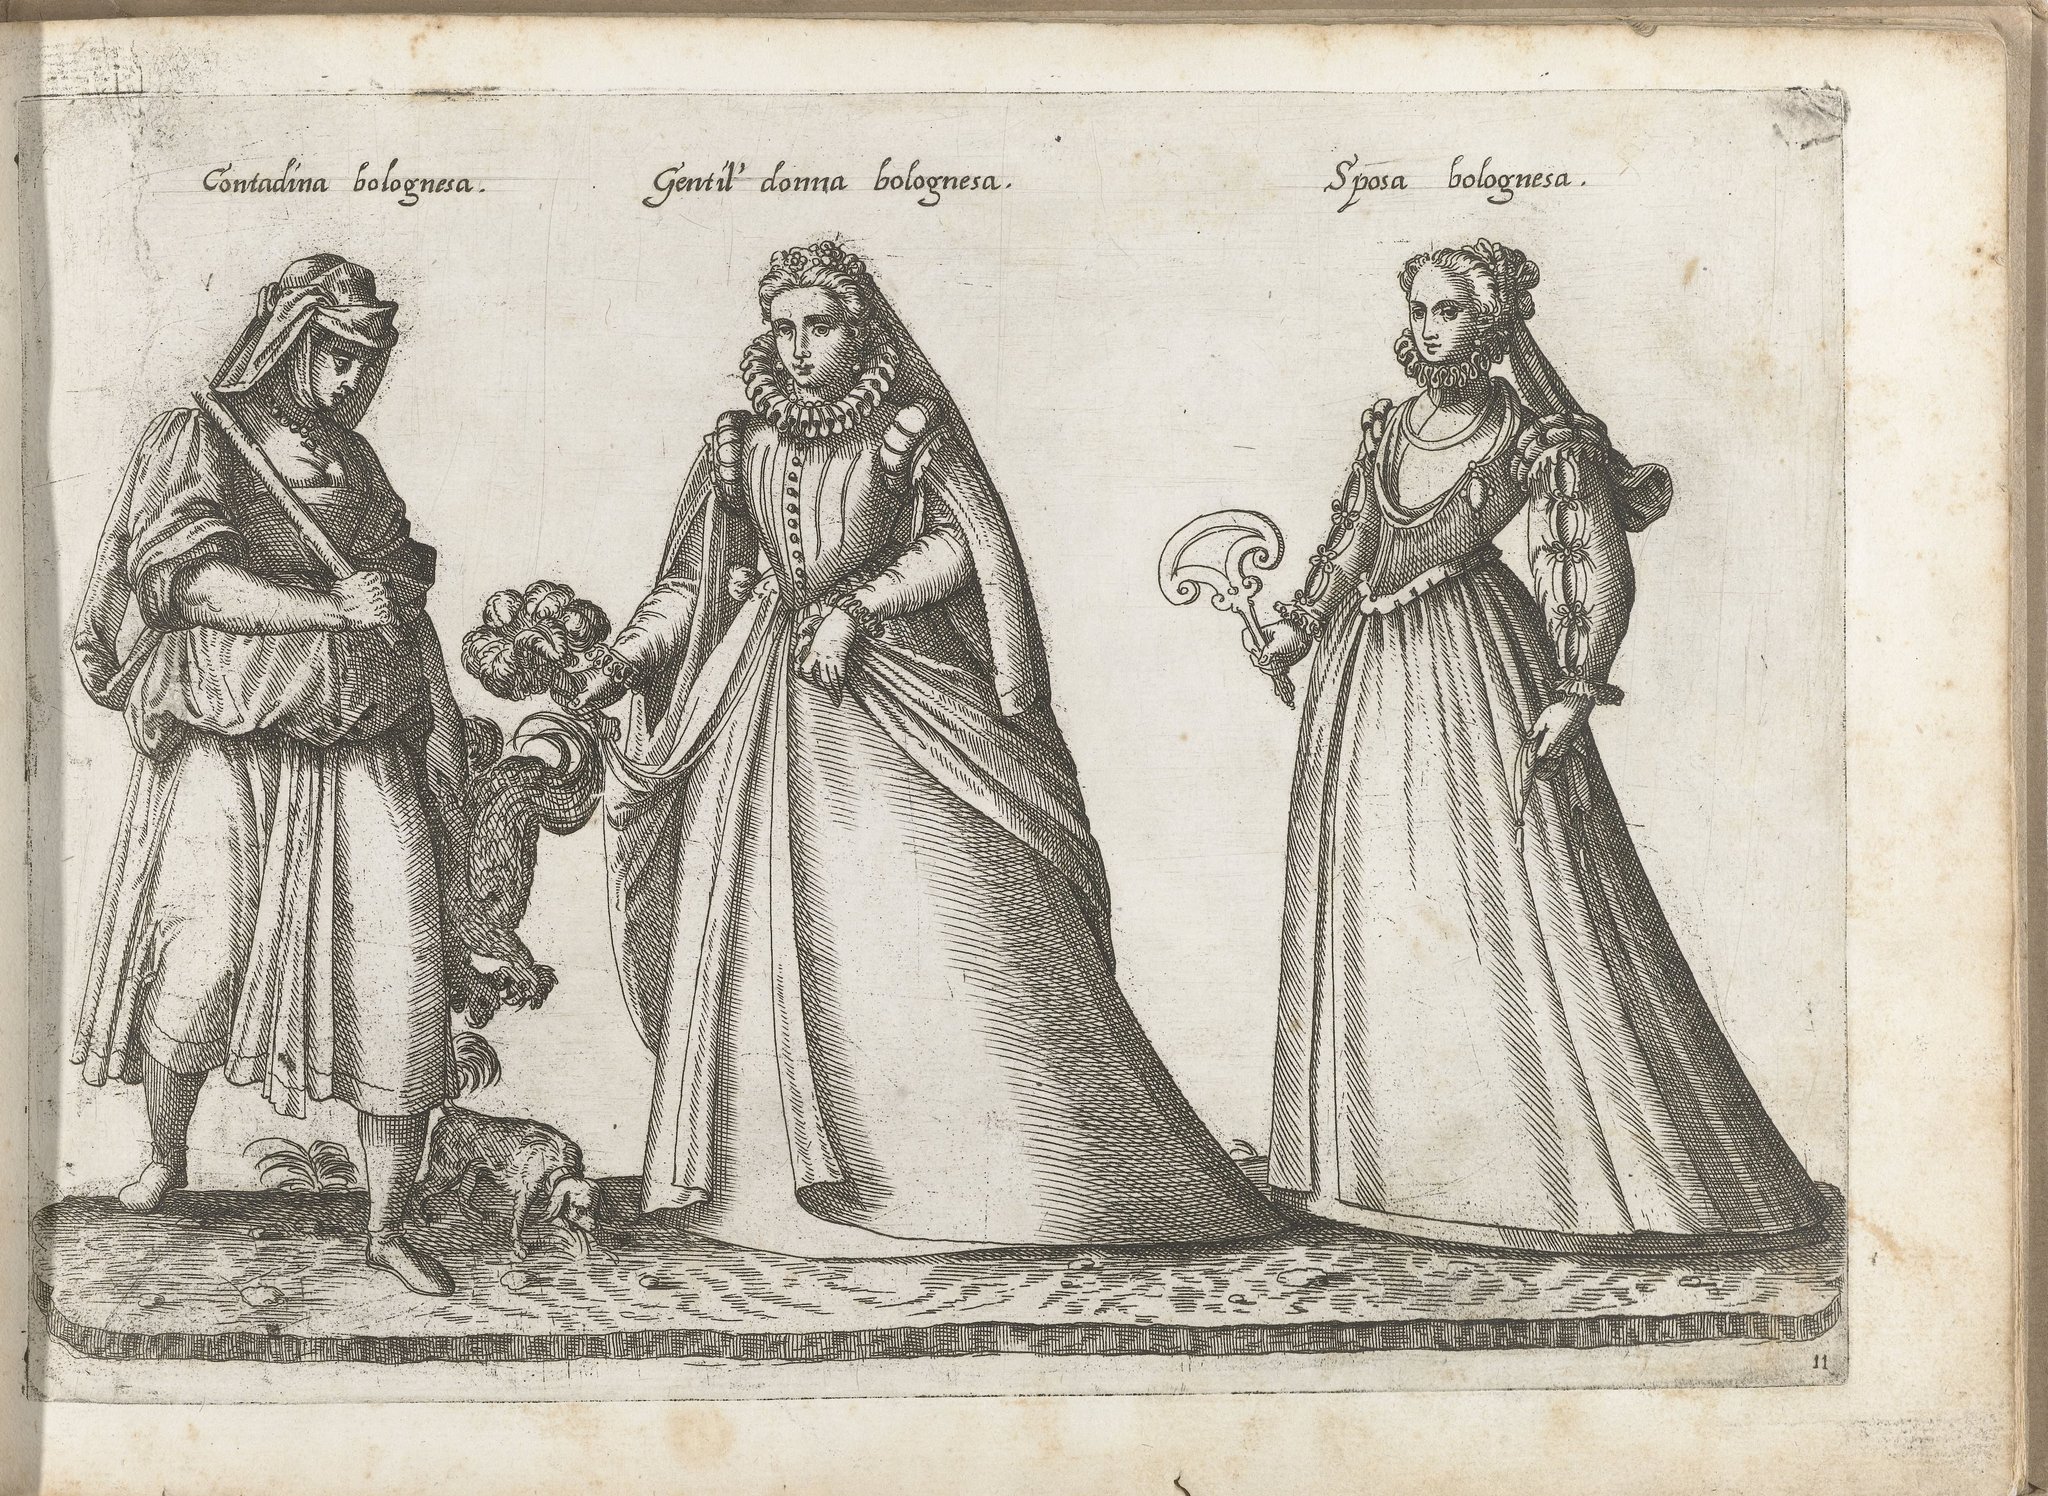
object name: costume print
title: Contadina bolognese / Gentil donna bolognesa / Sposa bolognesa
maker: bartolomeo grassi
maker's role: publisher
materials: paper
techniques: engraving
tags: fan, europeans (with name) (+ costume)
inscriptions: number: ‘10’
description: Prent nr. 11 uit album 'Dei veri ritratti degl'habiti di tvtte le parti del mondo intagliati in rame per opra di Bartolomeo Grassi', 1585.